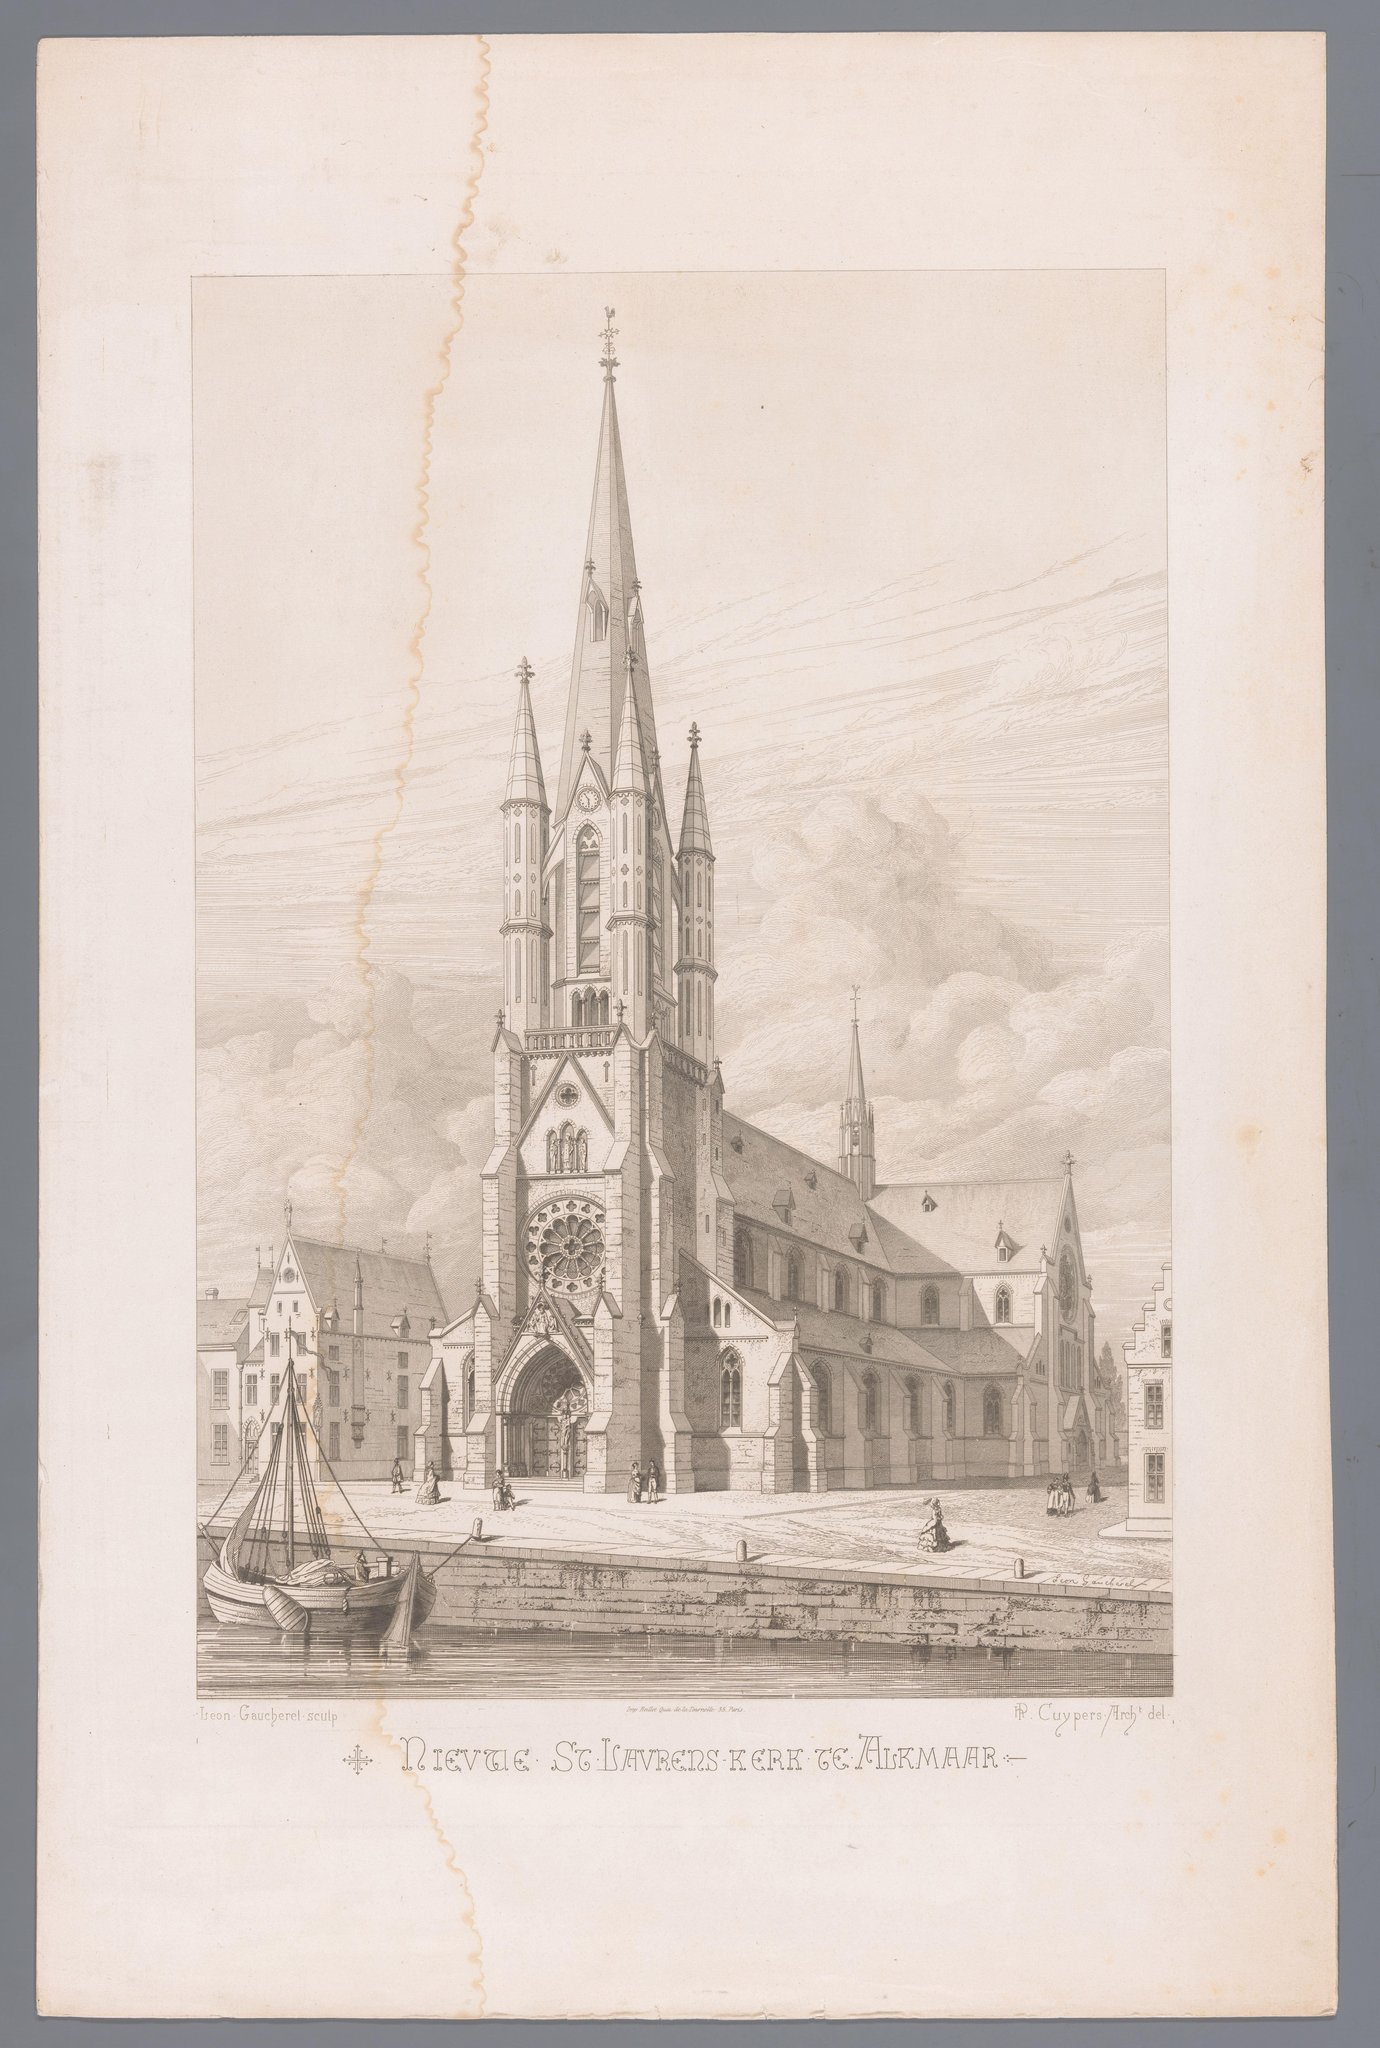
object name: print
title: Gezicht op de Sint-Laurenskerk te Alkmaar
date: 1826-1886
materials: paper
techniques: etching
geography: paris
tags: city-view, and landscape with man-made constructions, church (exterior)